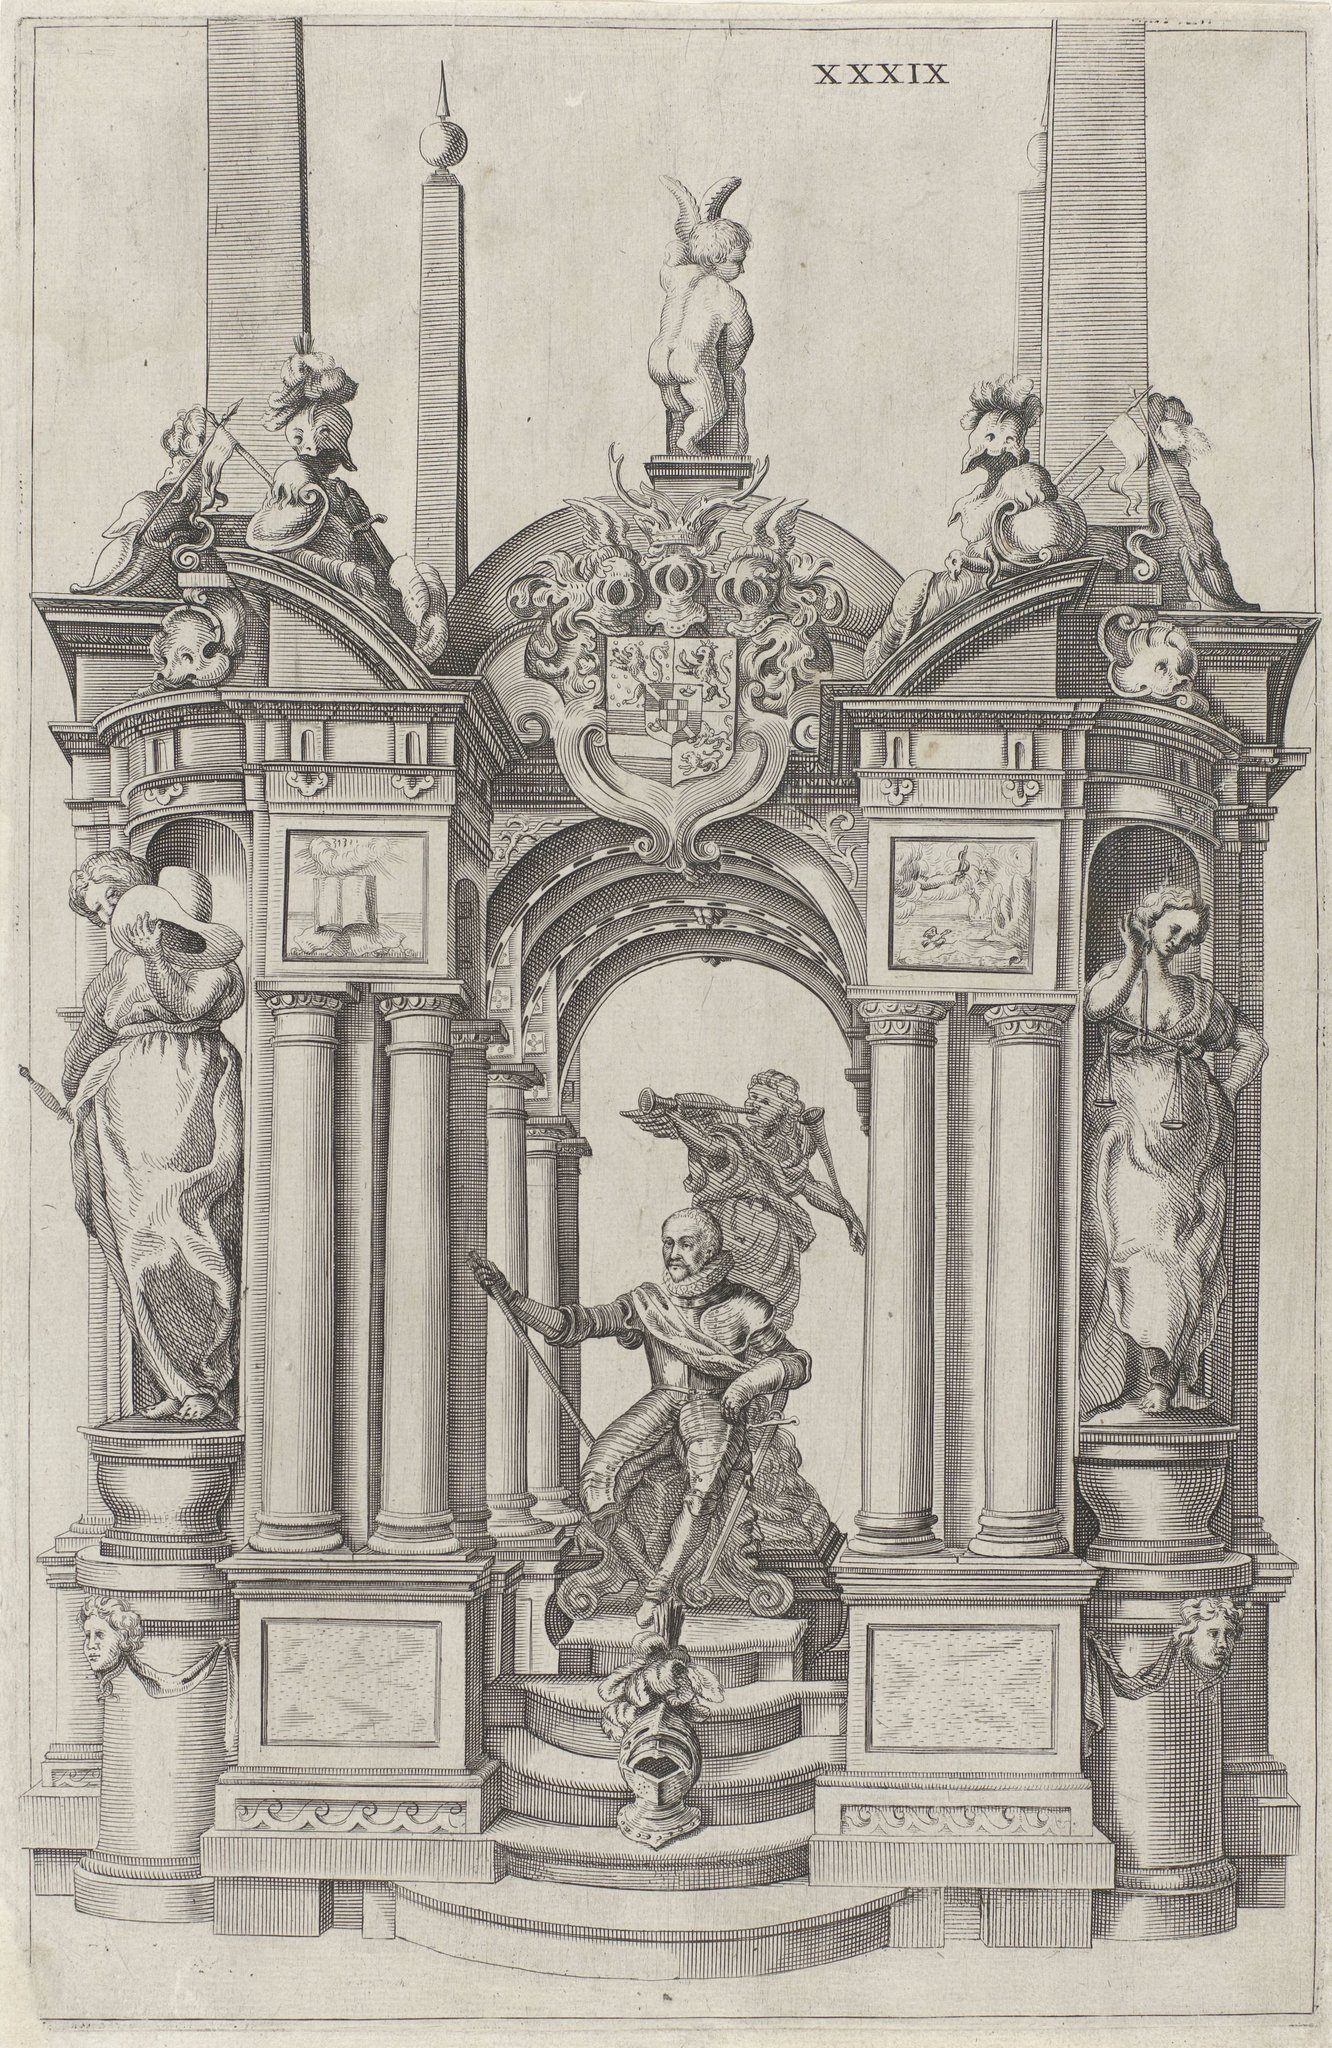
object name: book illustration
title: Architectura moderna ofte Bouwinge van onsen tyt (...) mr. Hendrick de Keyser (...) en Cornelis Danckerts (...) Amsterdam 1631, pl. XXXIX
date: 1631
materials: paper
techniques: engraving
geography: amsterdam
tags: william i (prince of orange), historical persons, interior of church, grave-building, monumental tomb, delft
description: De hier vermelde titel verwijst naar de hoogst verkregen titel van de geportretteerde, niet per se naar de titel die de geportretteerde op deze voorstelling draagt. Prent uit: Architectura moderna ofte bouwinge van onsen tyt (...) alle gedaen by (...) Hendrick de Keyser. Amsterdam: Cornelis Danckerts, 1631.